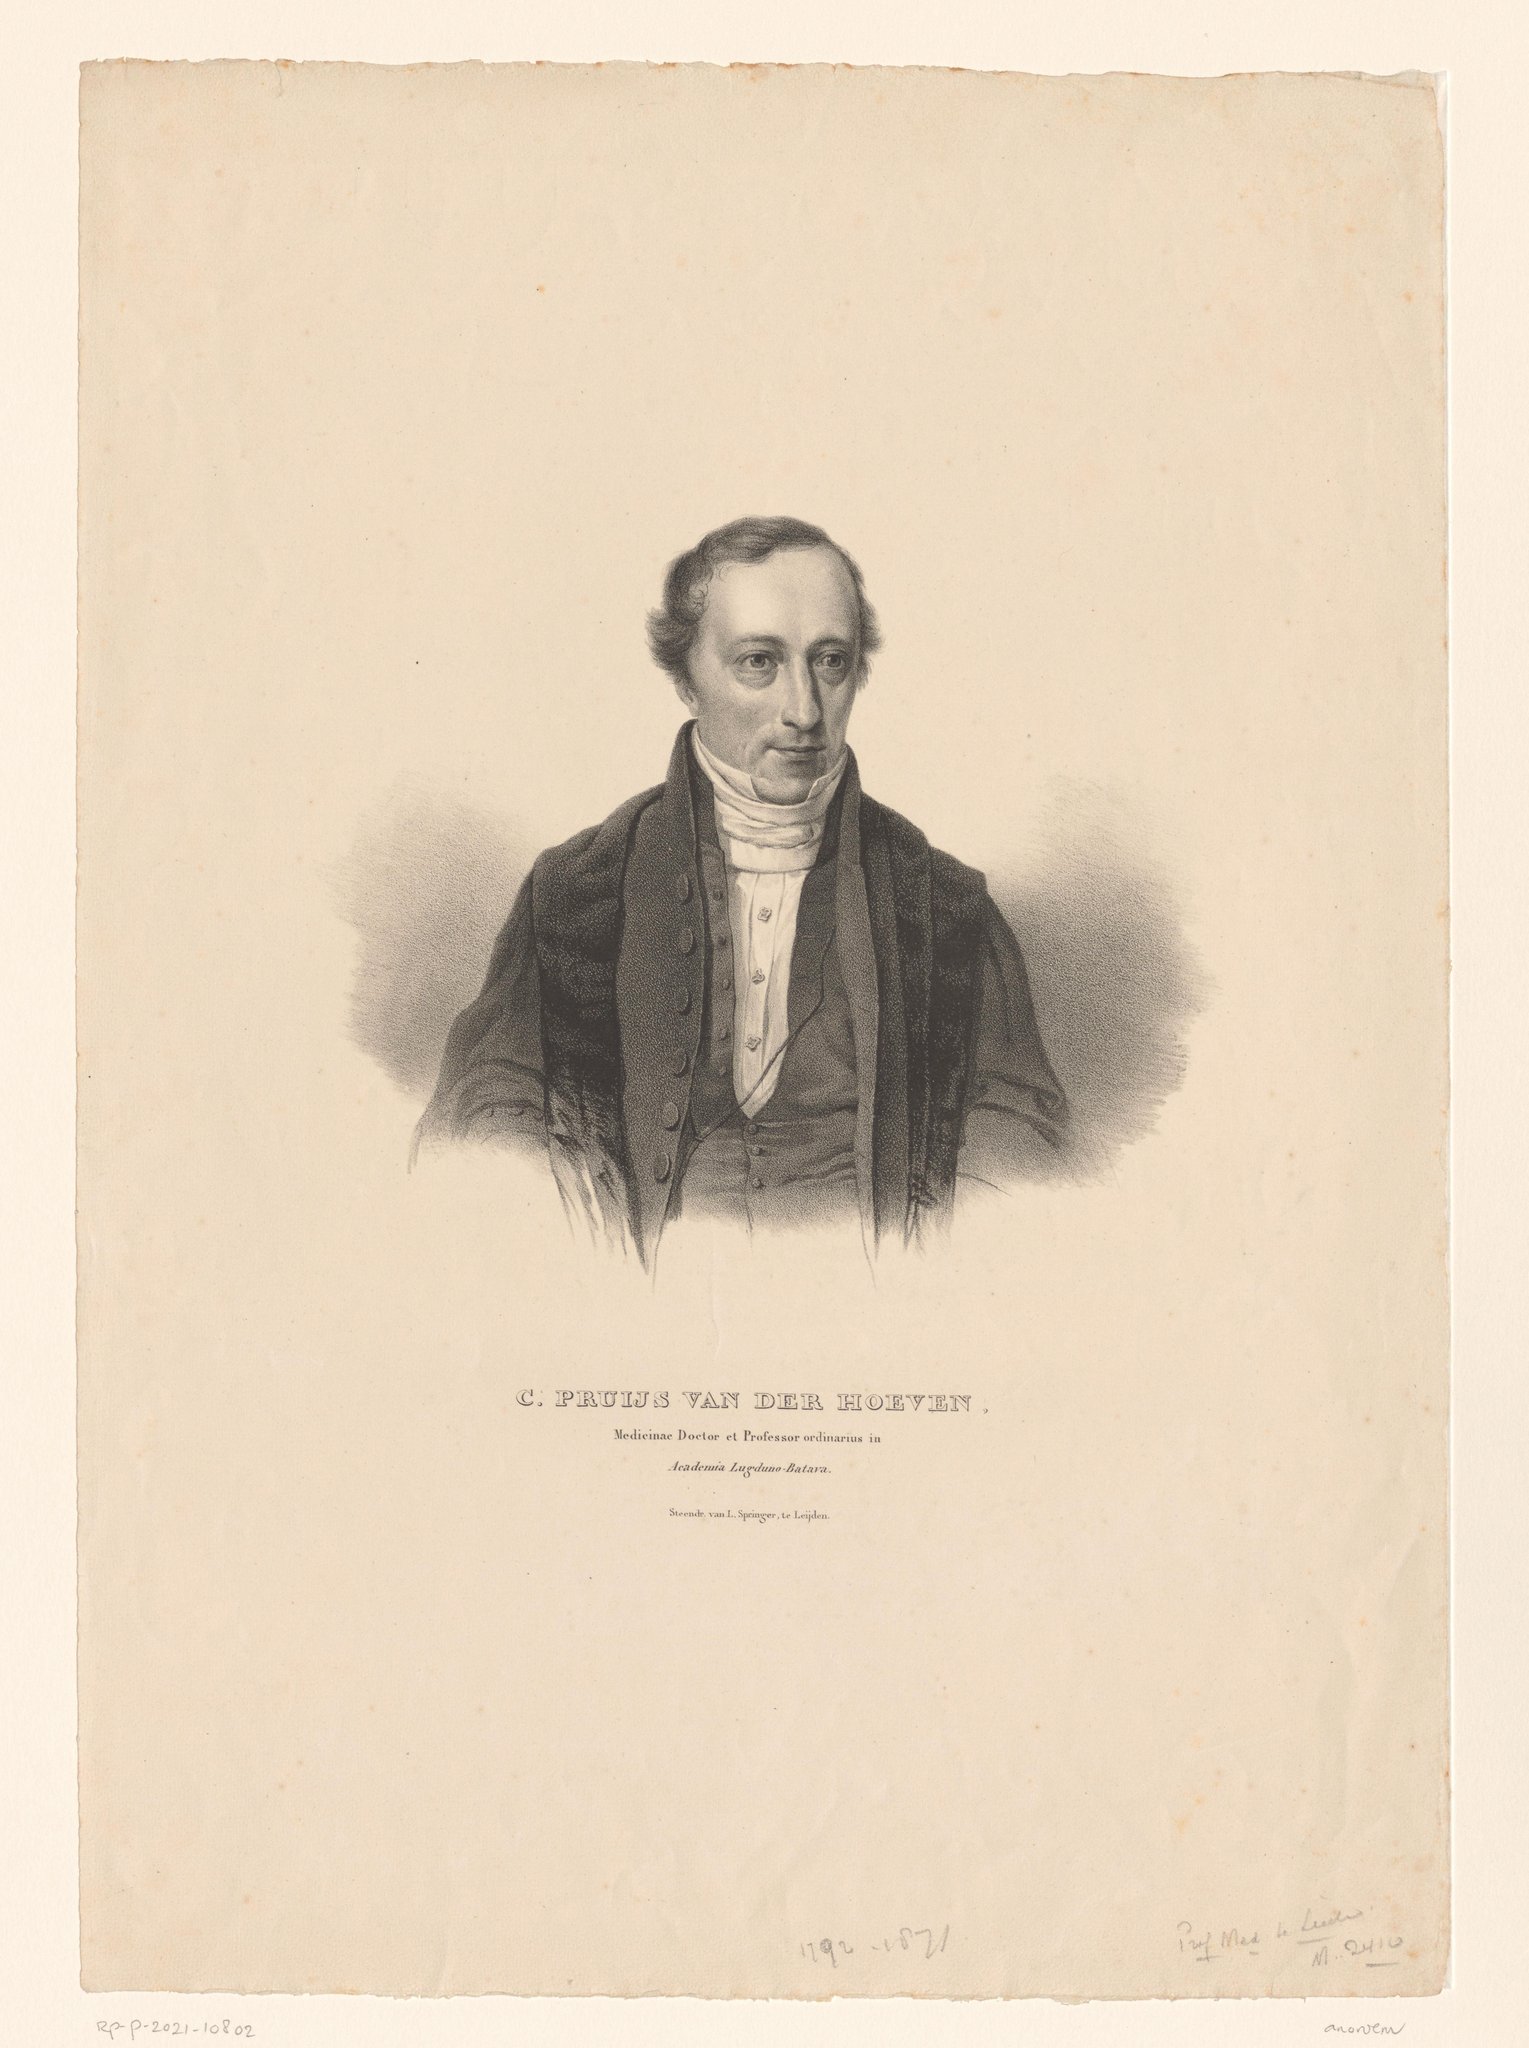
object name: print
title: Portret van Cornelis Pruijs van der Hoeven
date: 1824-1853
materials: paper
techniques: lithograph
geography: leiden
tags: rotterdam, leiden, historical persons, physician, doctor